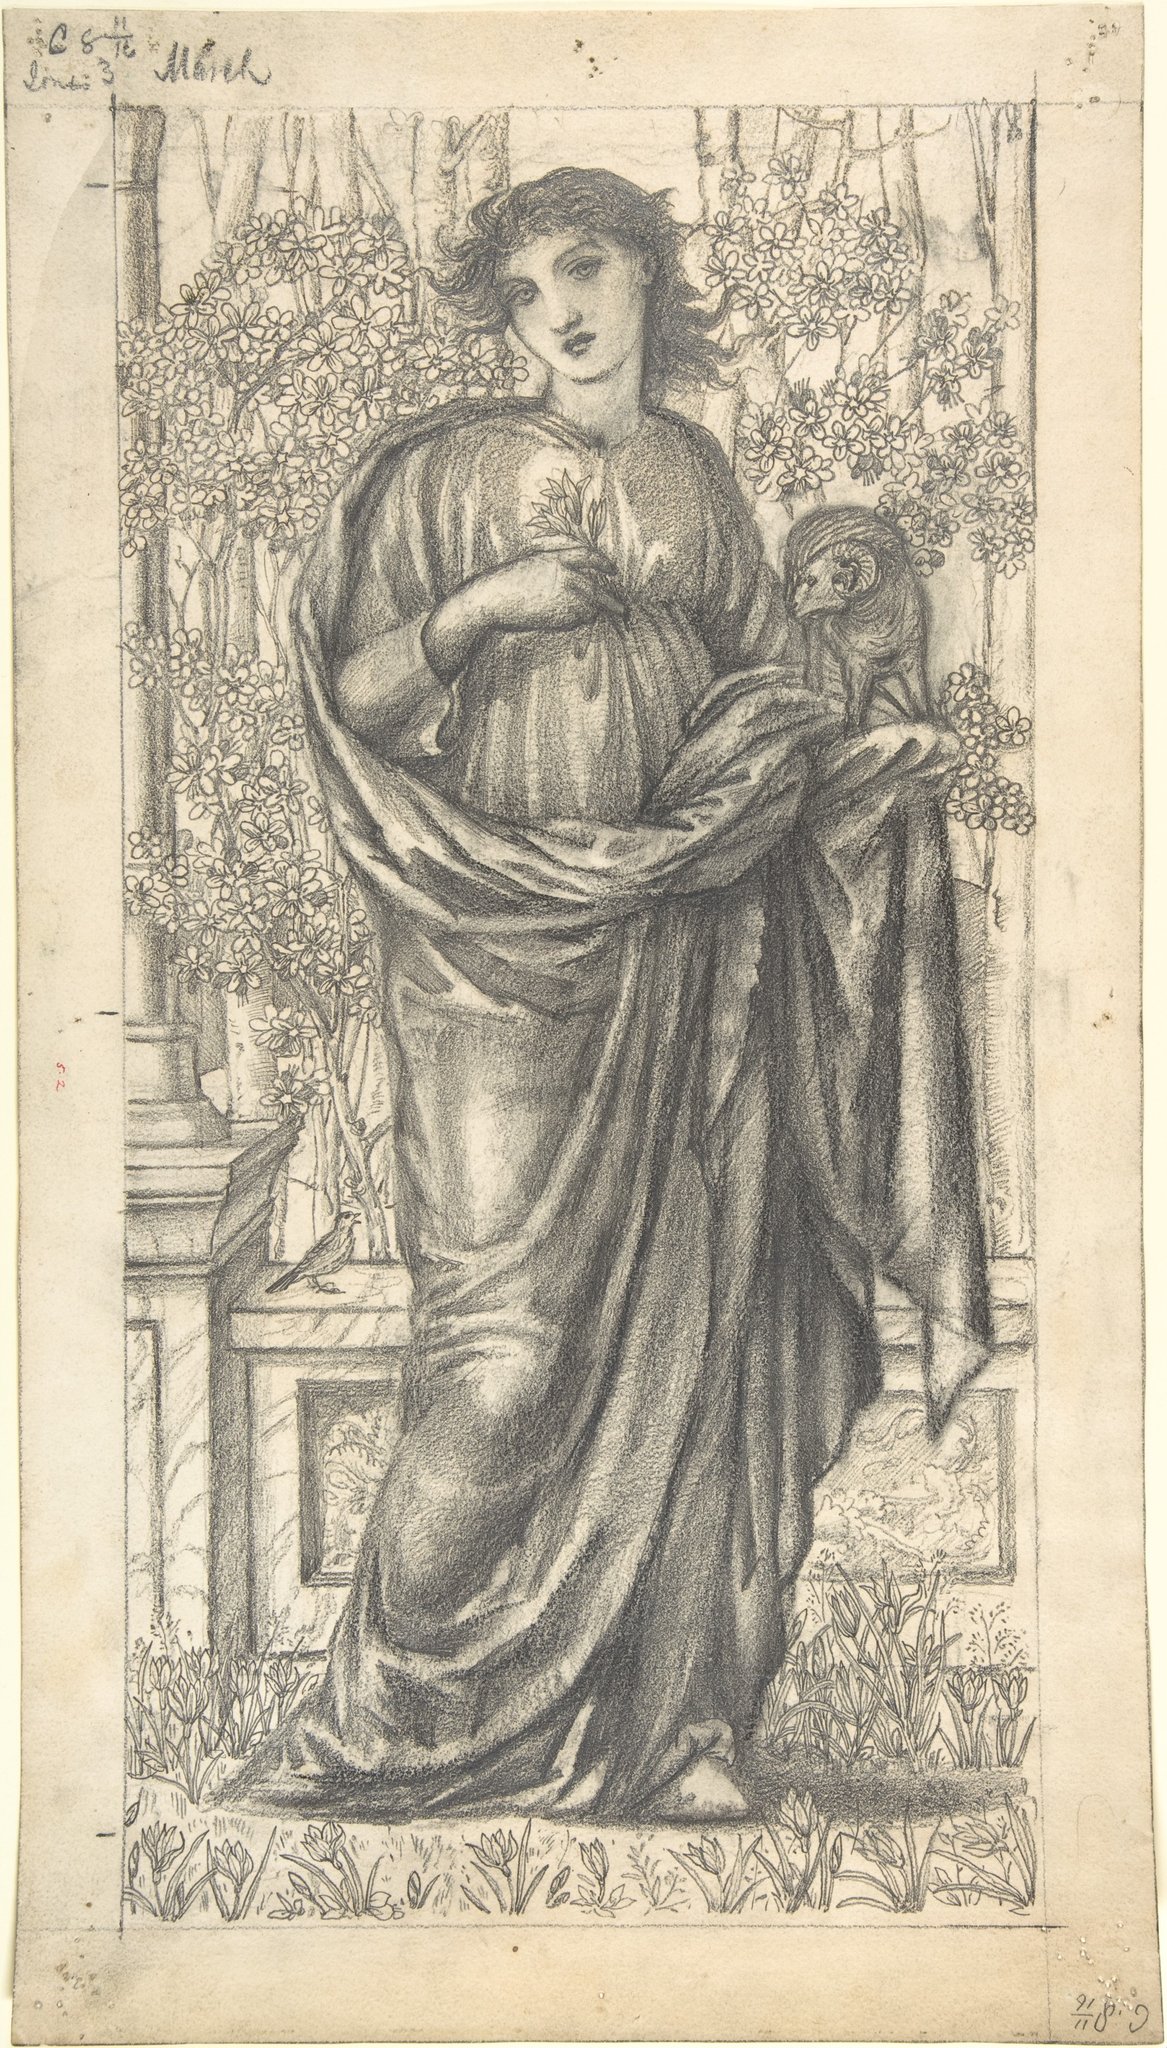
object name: drawing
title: The Month of March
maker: sir edward burne-jones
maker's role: artist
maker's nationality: british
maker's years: 1833-1898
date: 1866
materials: graphite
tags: animals,women,flowers,trees